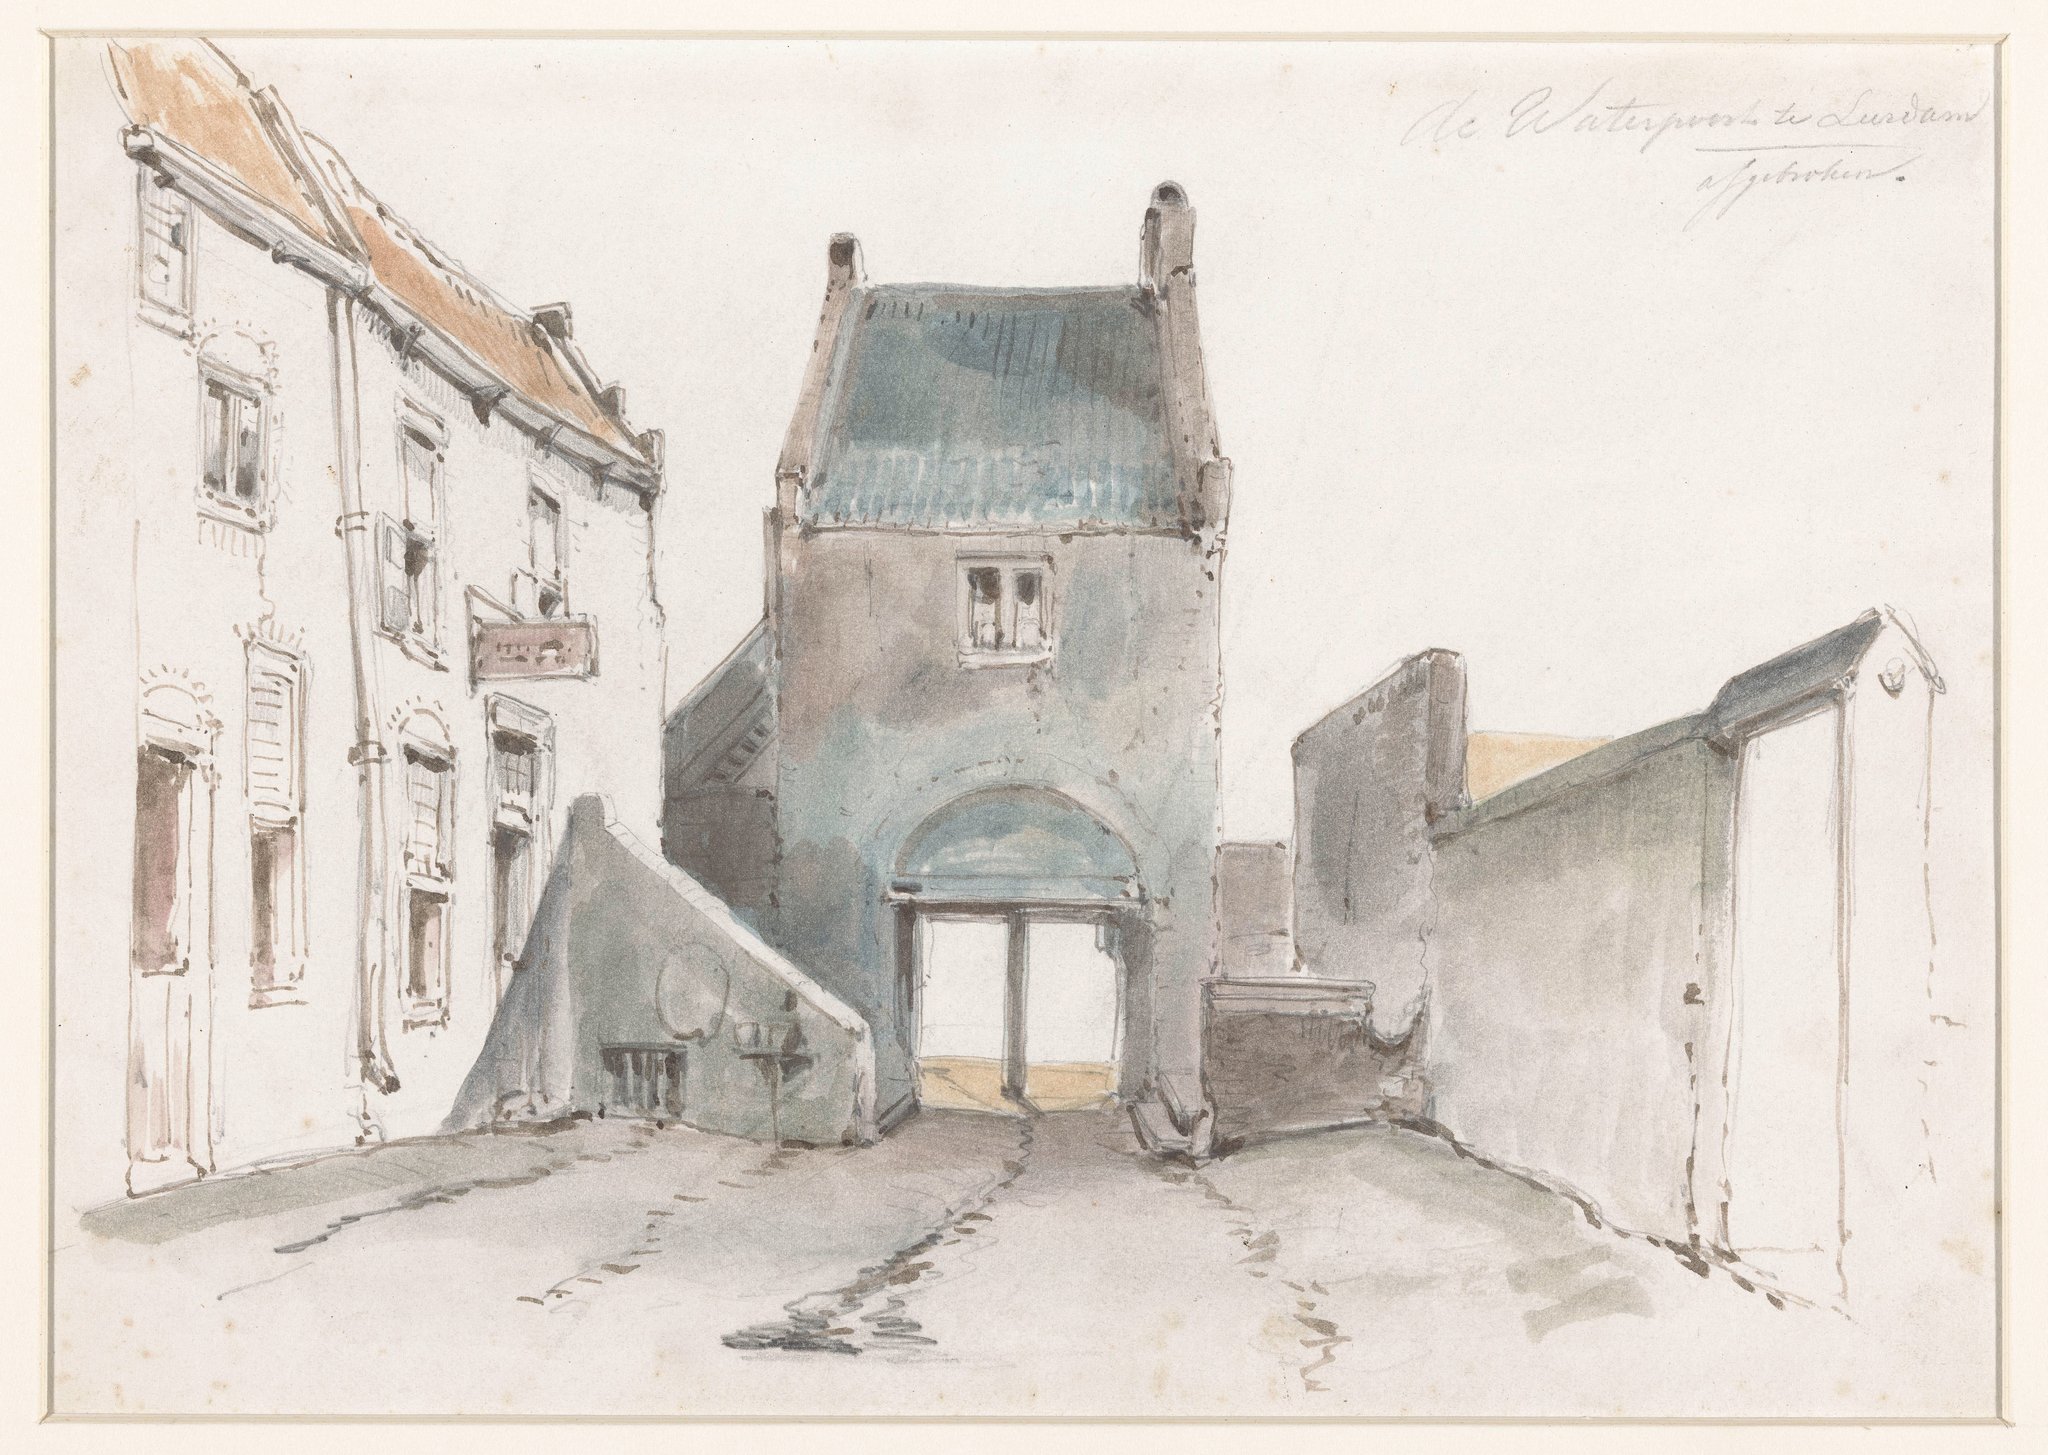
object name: drawing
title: Waterpoort te Leerdam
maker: jan weissenbruch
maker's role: painter, print maker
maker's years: 1822-1880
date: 1832-1880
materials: ink, paper, pencil, watercolor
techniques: brush, pen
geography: leerdam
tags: city-view, and landscape with man-made constructions